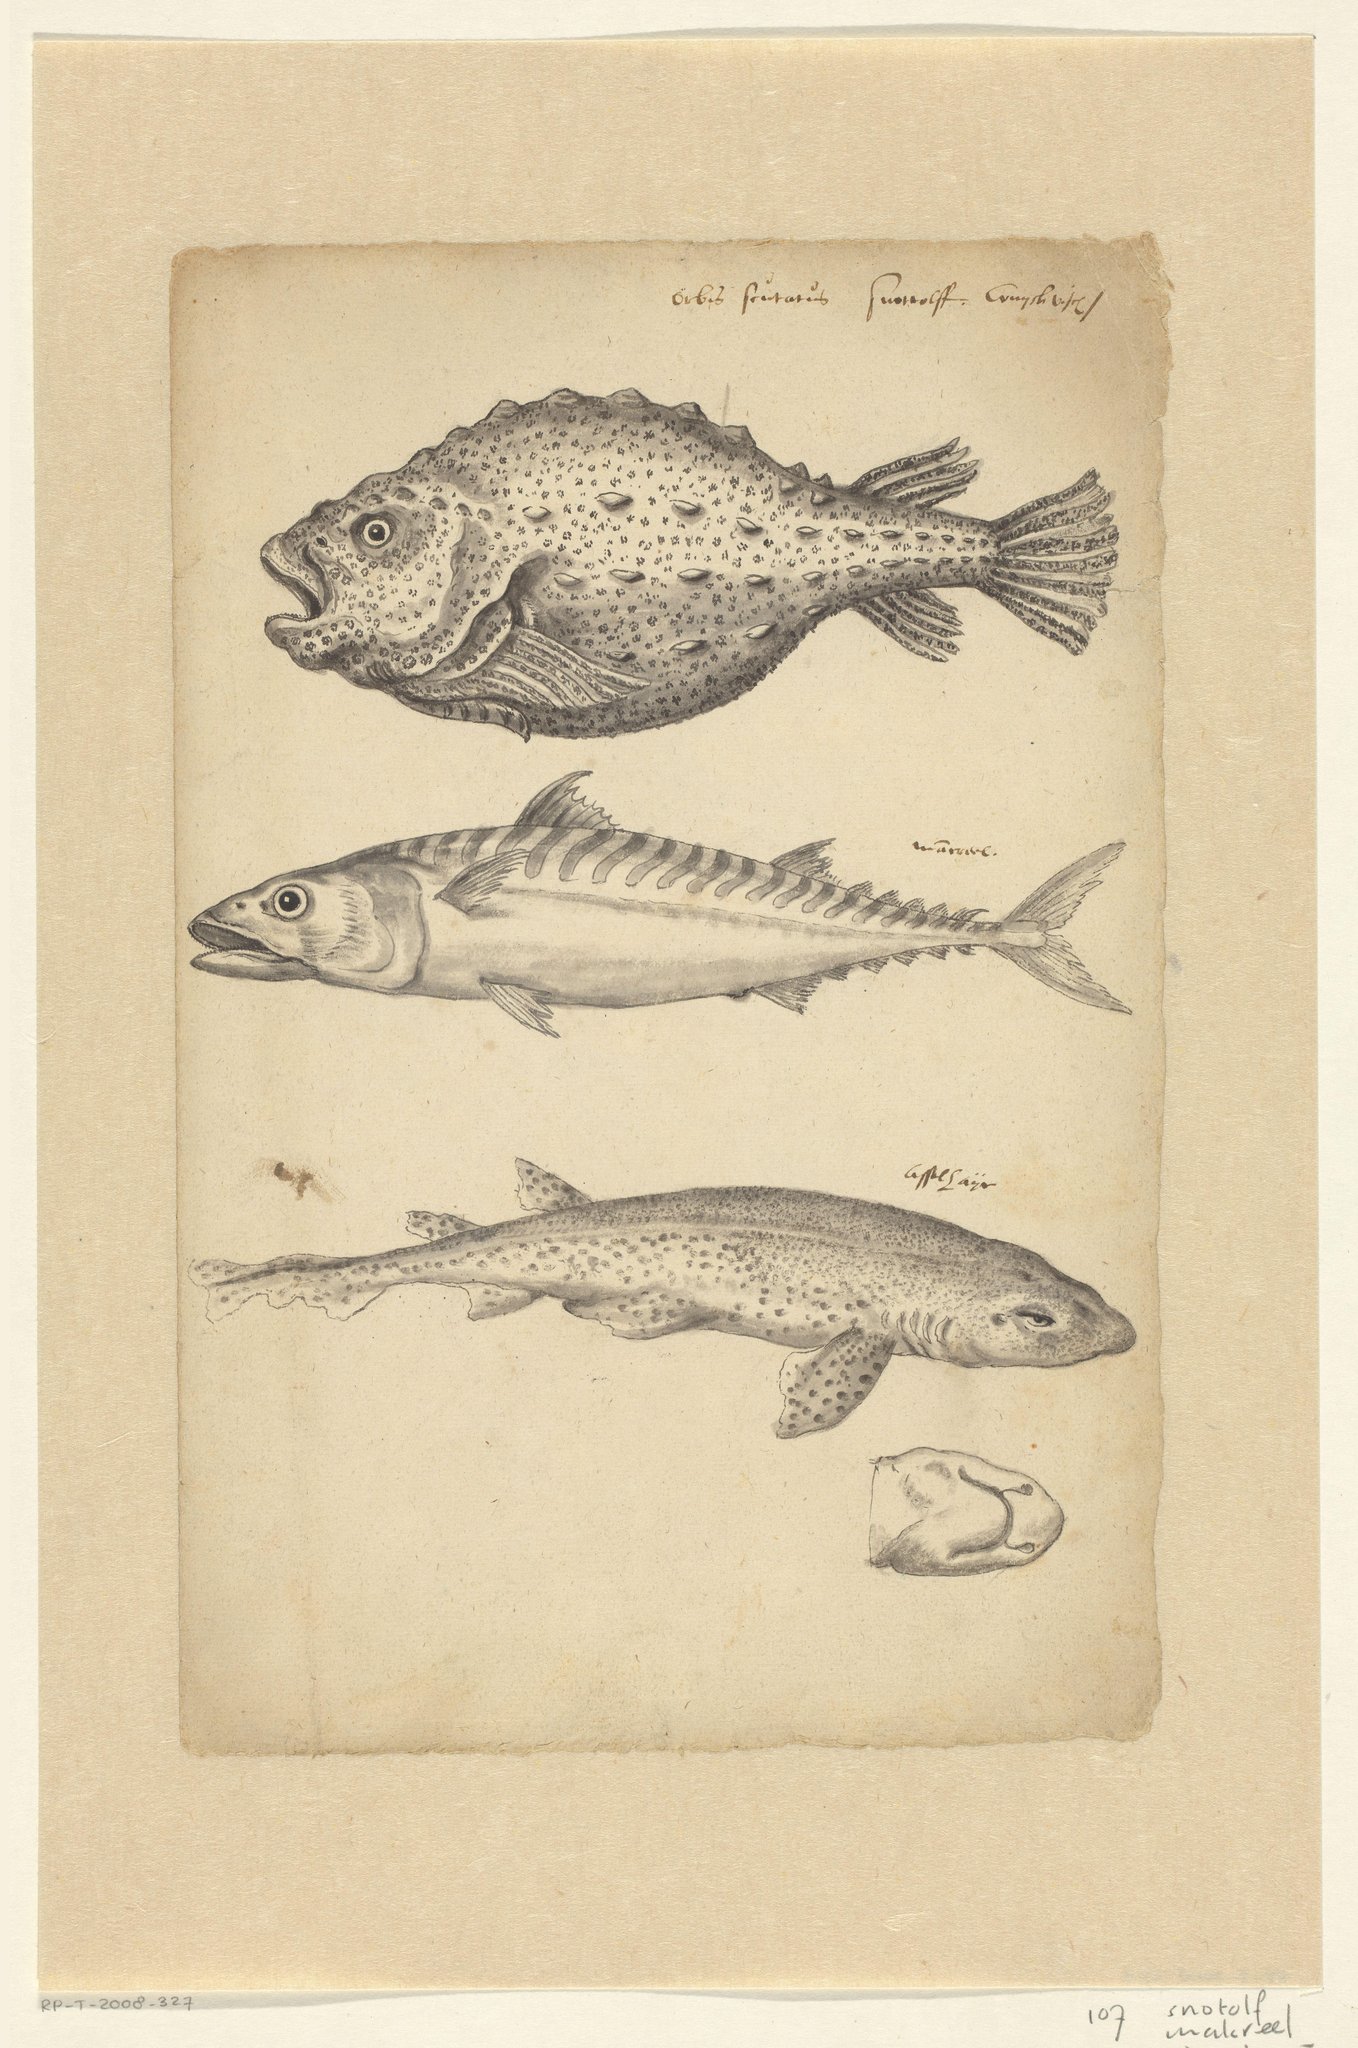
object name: drawing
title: Study sheet with a lumpfish (Cyclopterus lumpus), a mackerel (Scomber scombrus) and a small-spotted catshark (Scyliorhinus canicula)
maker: Anonymous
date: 1575-1599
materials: ink, paper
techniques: brush, pen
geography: netherlands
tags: fishes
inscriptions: inscription: ‘mācreel’, inscription: ‘Asselhaije’, inscription: ‘Orbis scutatus, Snottolf, Cruyckvisch’